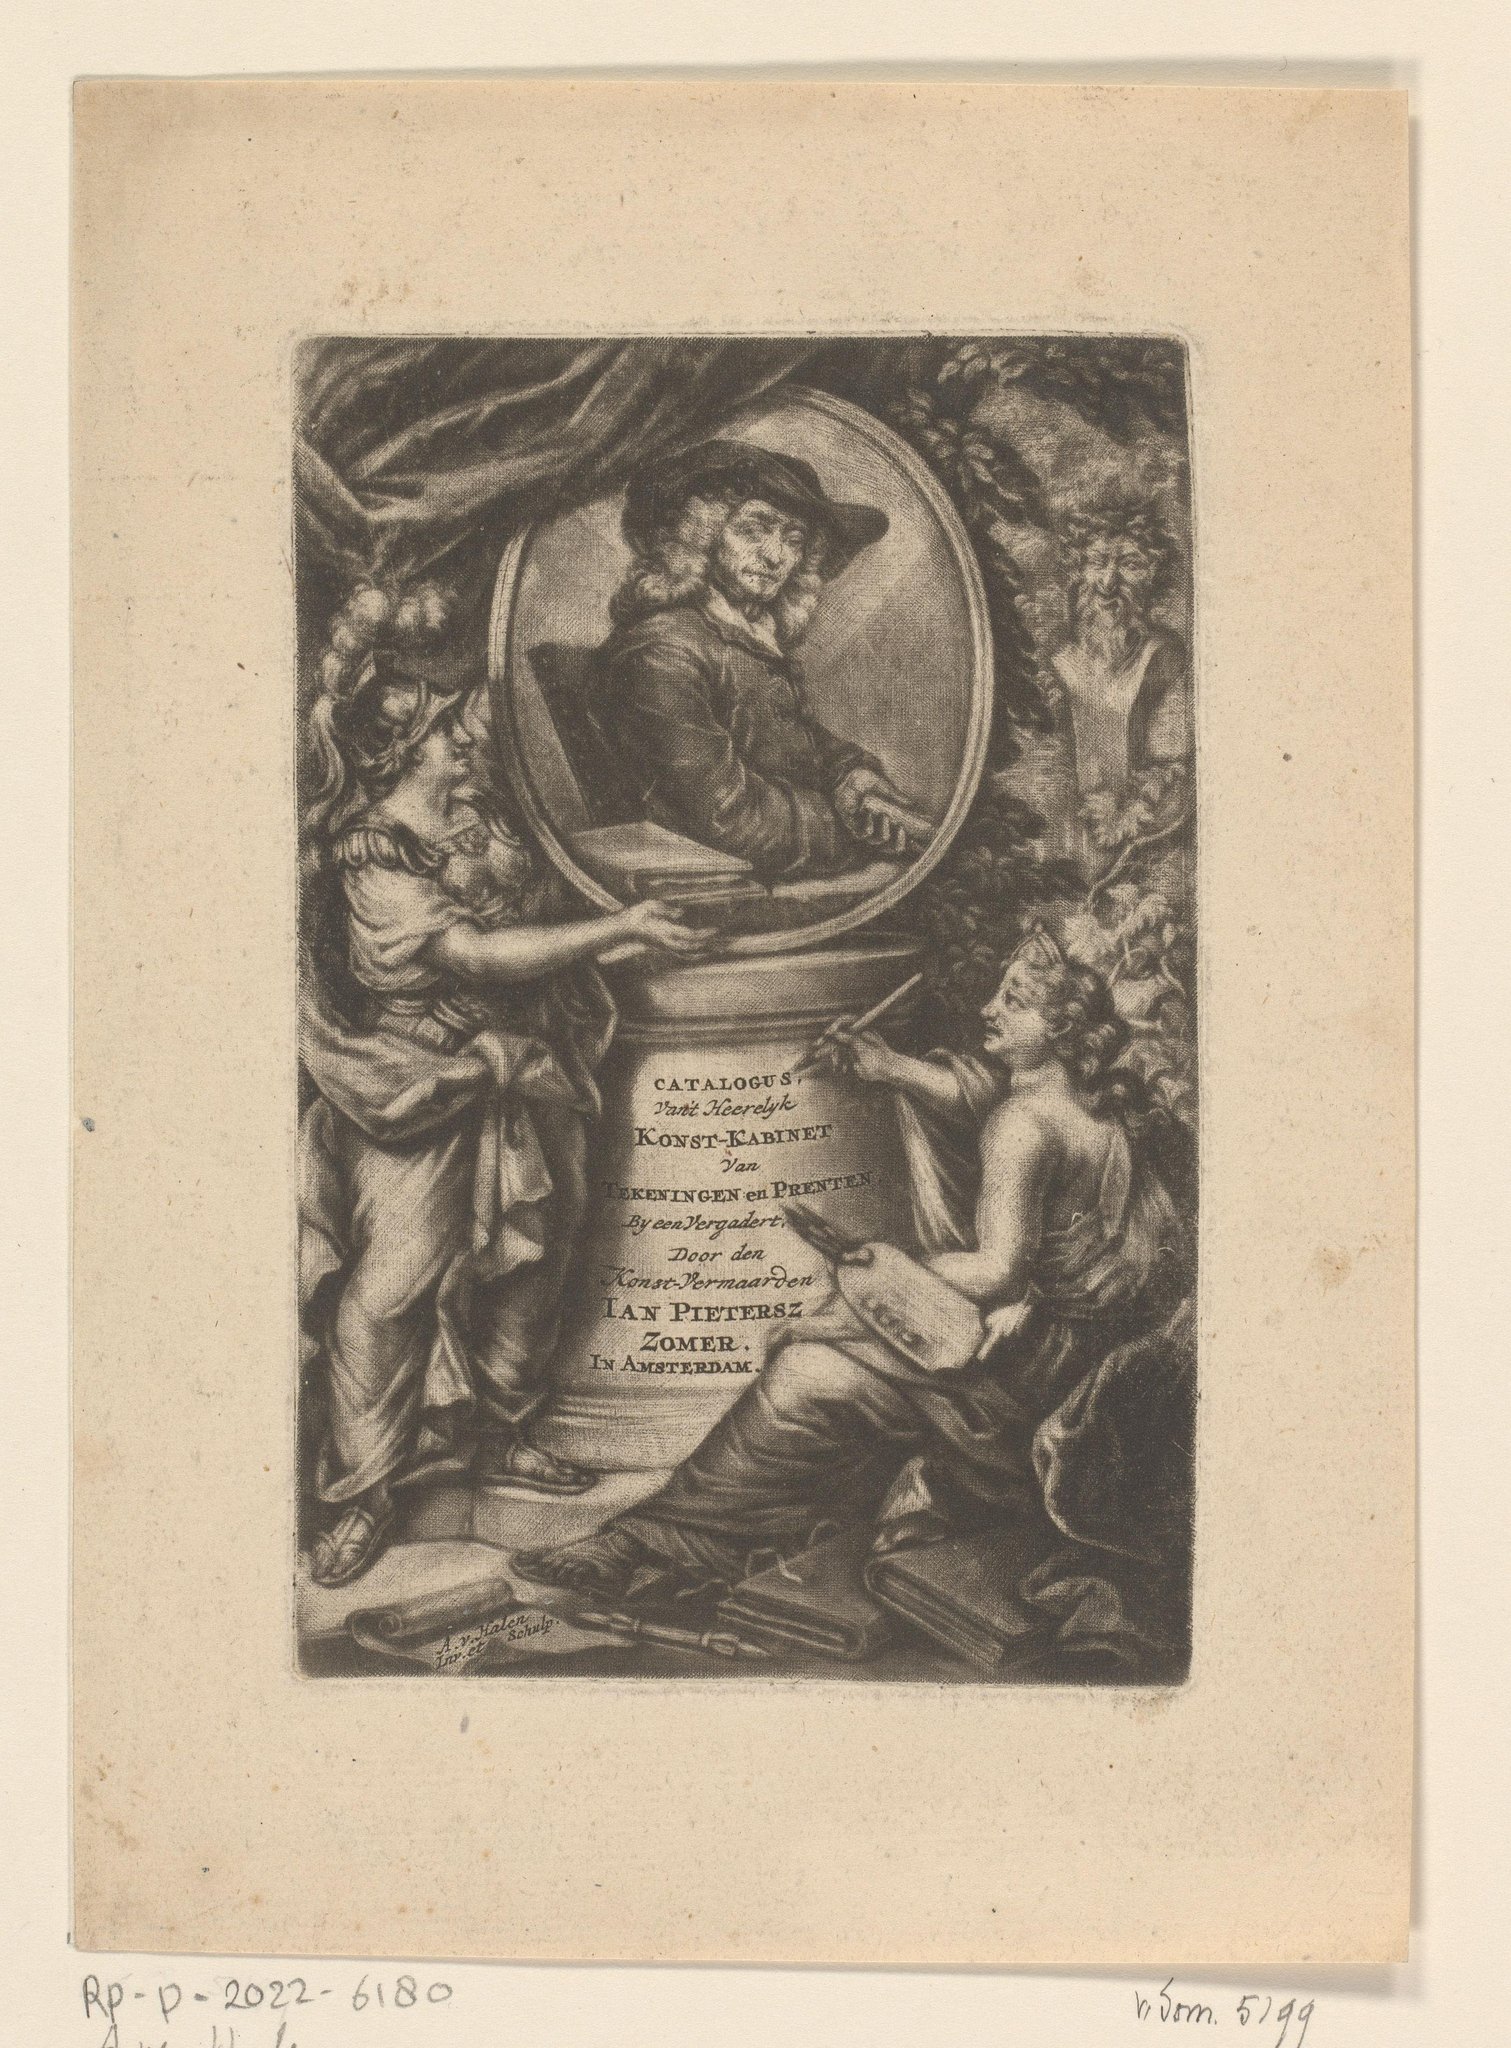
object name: titelblad, titelpagina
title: Portret van Jan Pietersz. Zomer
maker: arnoud van halen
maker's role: draughtsman, painter, print maker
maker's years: 1673-1732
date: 1720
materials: paper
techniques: engraving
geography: amsterdam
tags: draughtsman, jan pietersz. zomer, print, e.g.: engraving, etching, lithograph, historical persons, art dealer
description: Prent waarschijnlijk uit: Zomer, Jan Pietersz. Catalogus van een uytstekend heerlyk cabinet van teekeningen, (...). S.l.s.n., 1720.